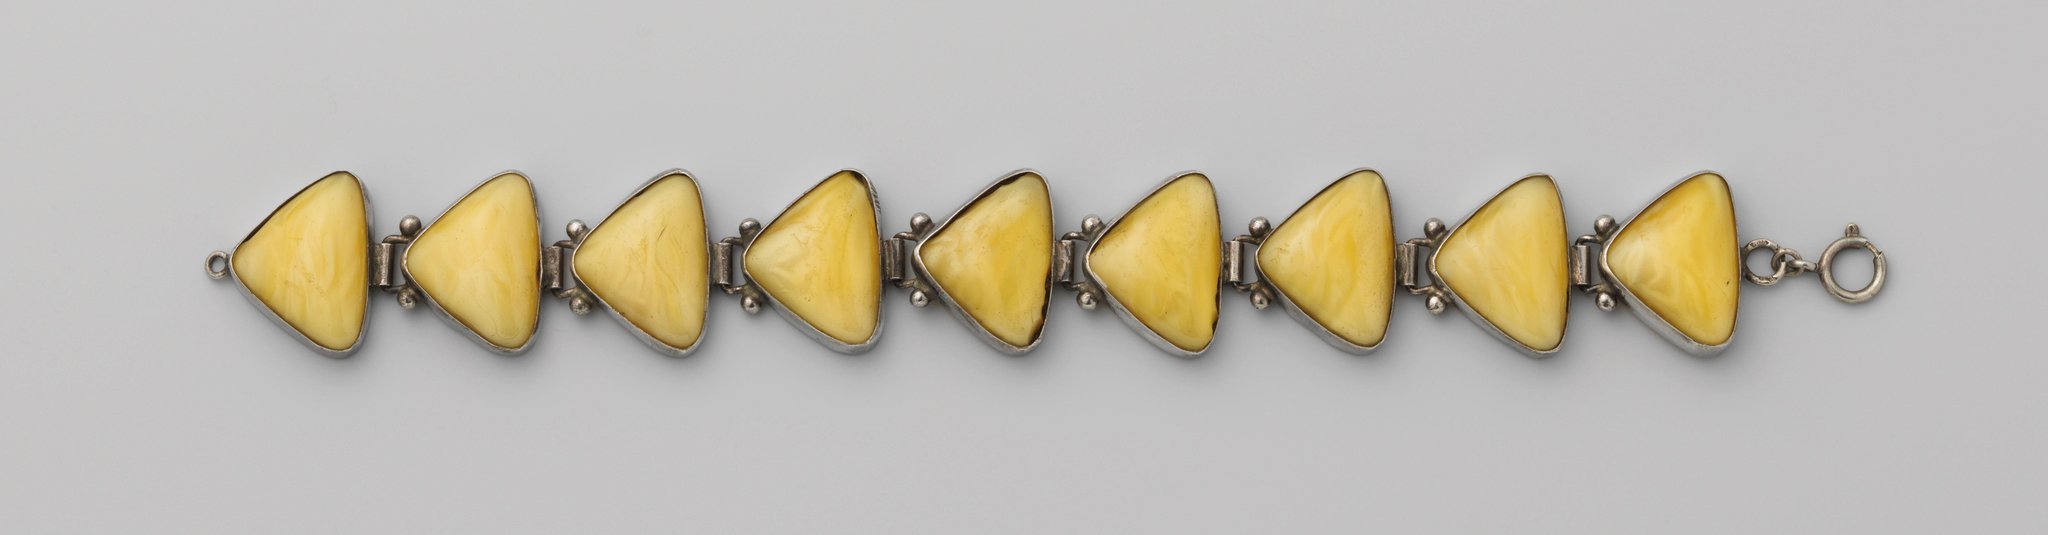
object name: chain bracelet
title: Schakelarmband van zilver en geel persglas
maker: Anonymous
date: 1940-1950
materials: glass, silver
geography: netherlands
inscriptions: maker's mark, alloy mark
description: Schakelarmband van zilver met negen driehoekige schakels van geel persglas. De armband sluit met een veerring.